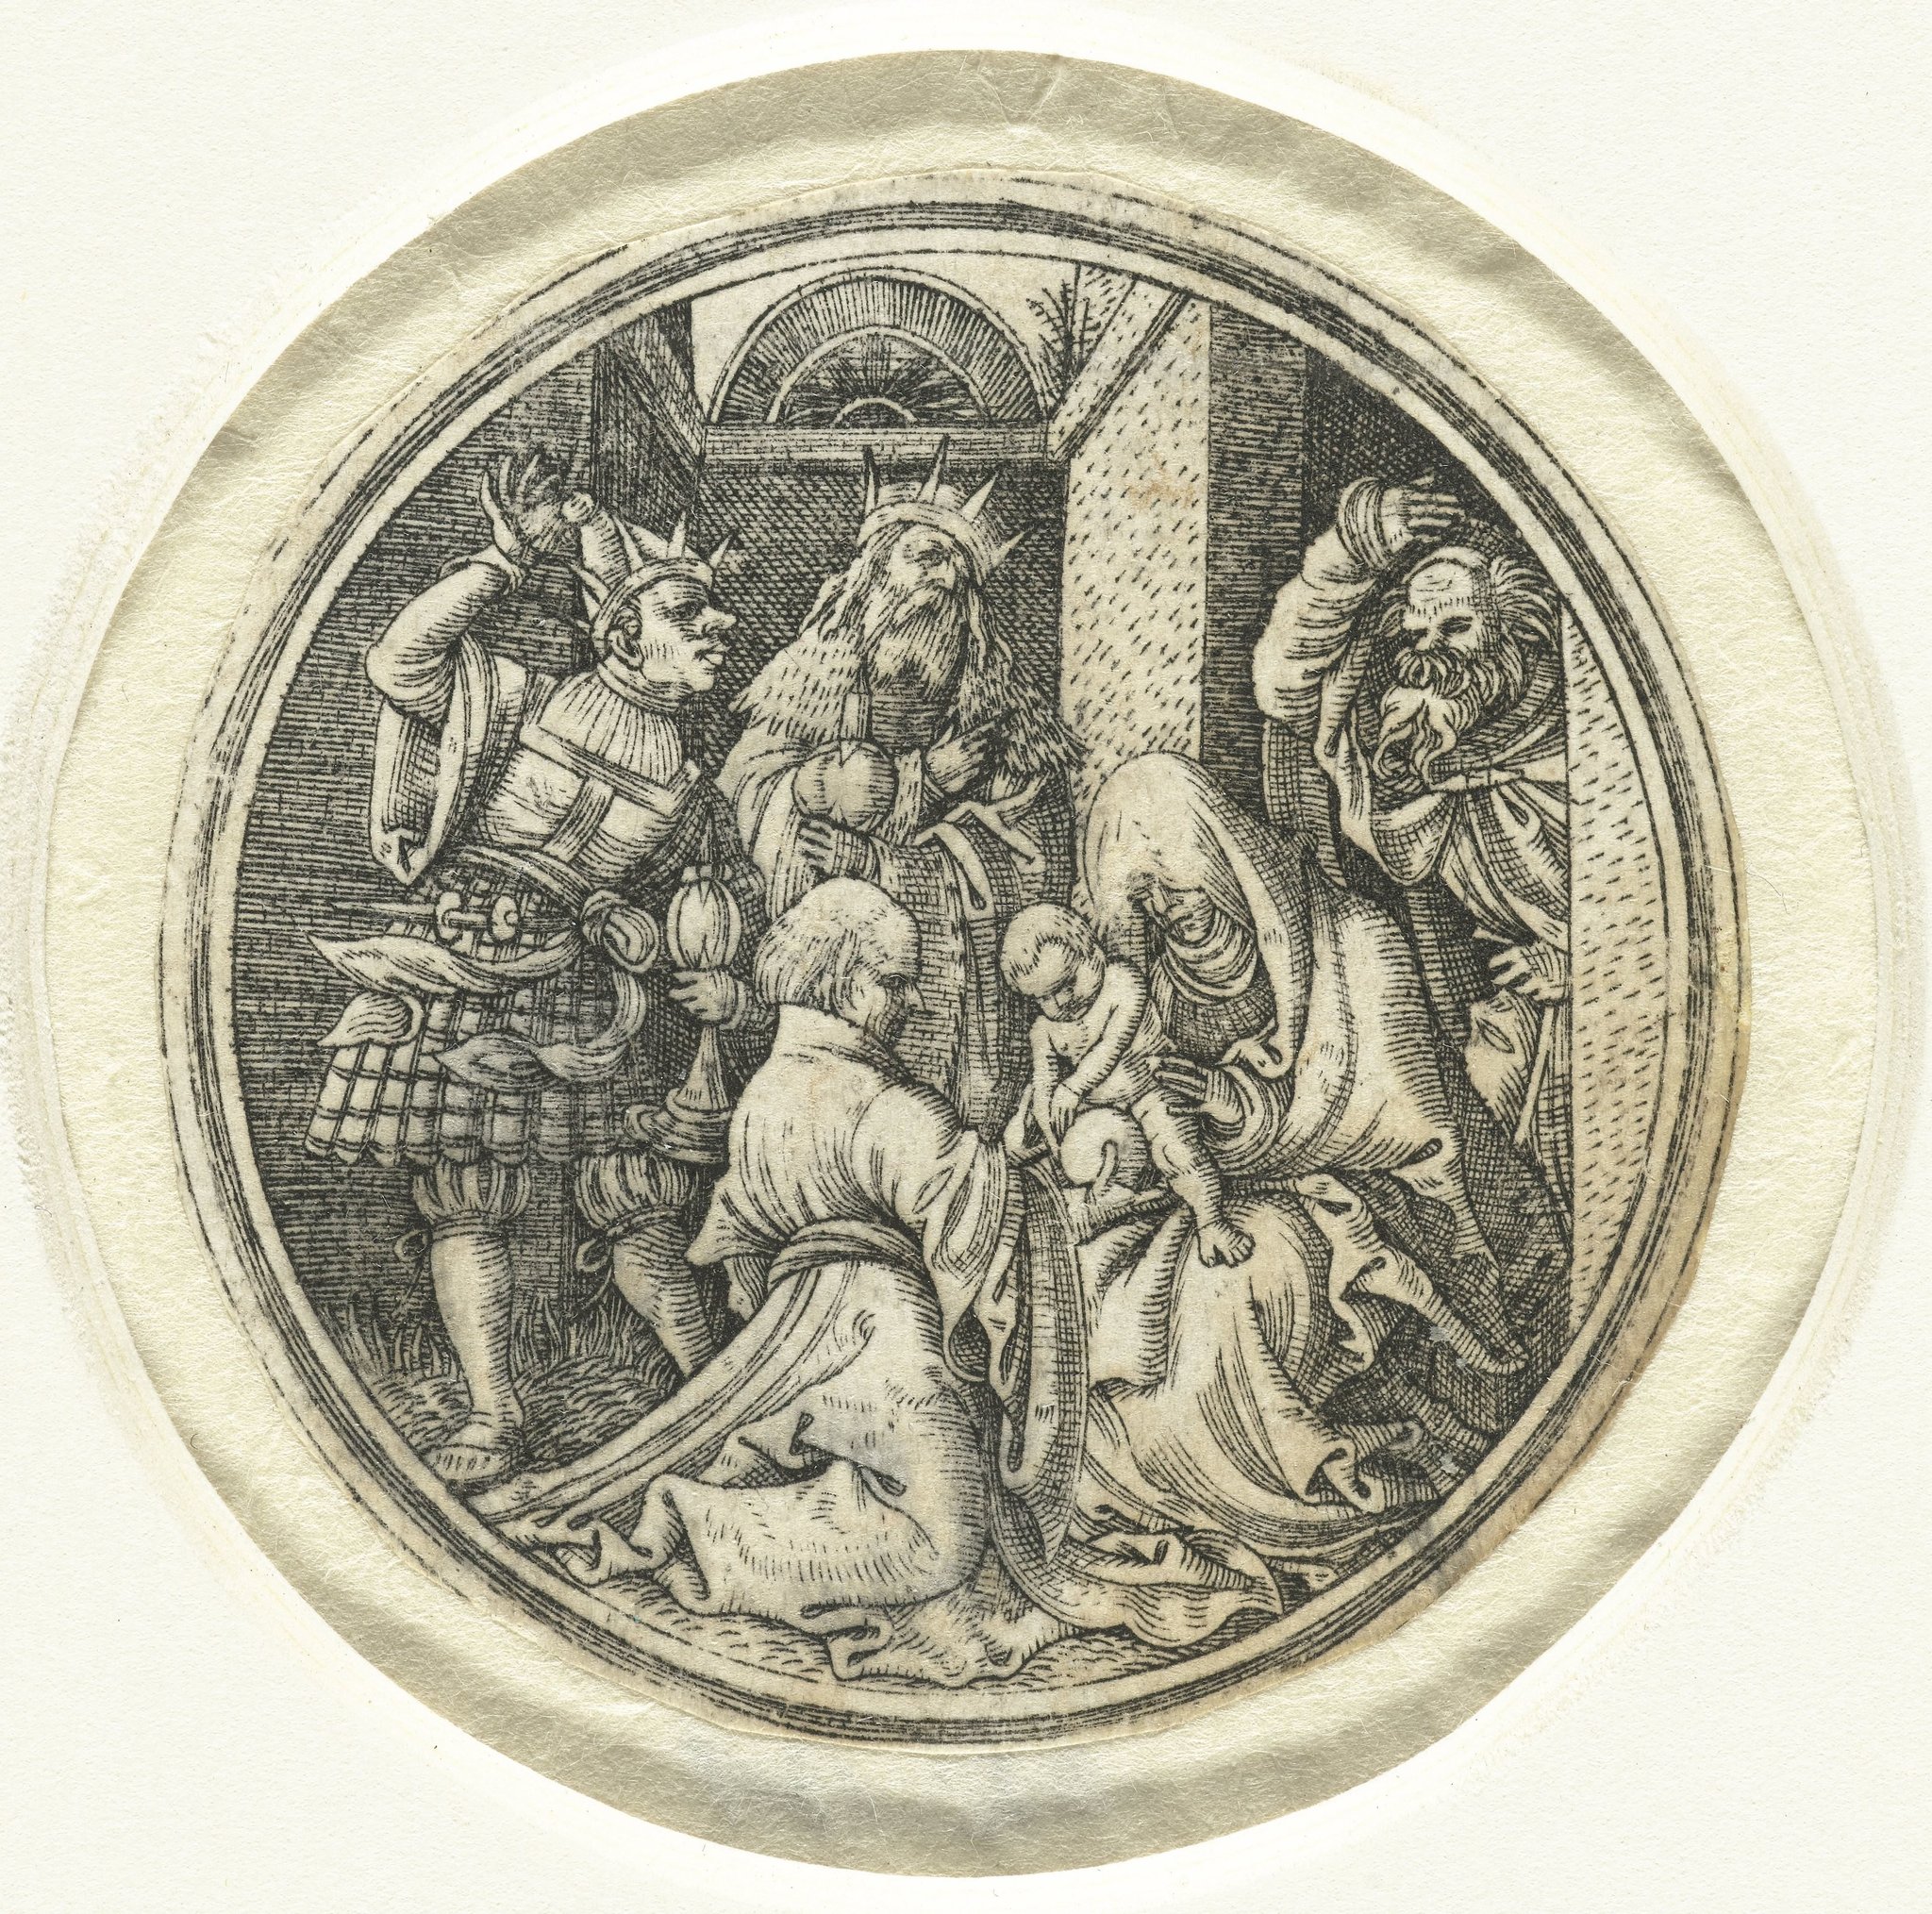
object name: print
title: Aanbidding der koningen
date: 1505-1533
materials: paper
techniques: engraving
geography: germany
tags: adoration of the kings: the wise men present their gifts to the christ-child (gold, frankincense and myrrh)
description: Maria met het Christuskind op schoot, achter haar staat Jozef. Drie koningen waarvan één geknield, bieden geschenken aan. Was samen met de geboorte van Christus onderdeel van twee voorstellingen op één plaat.